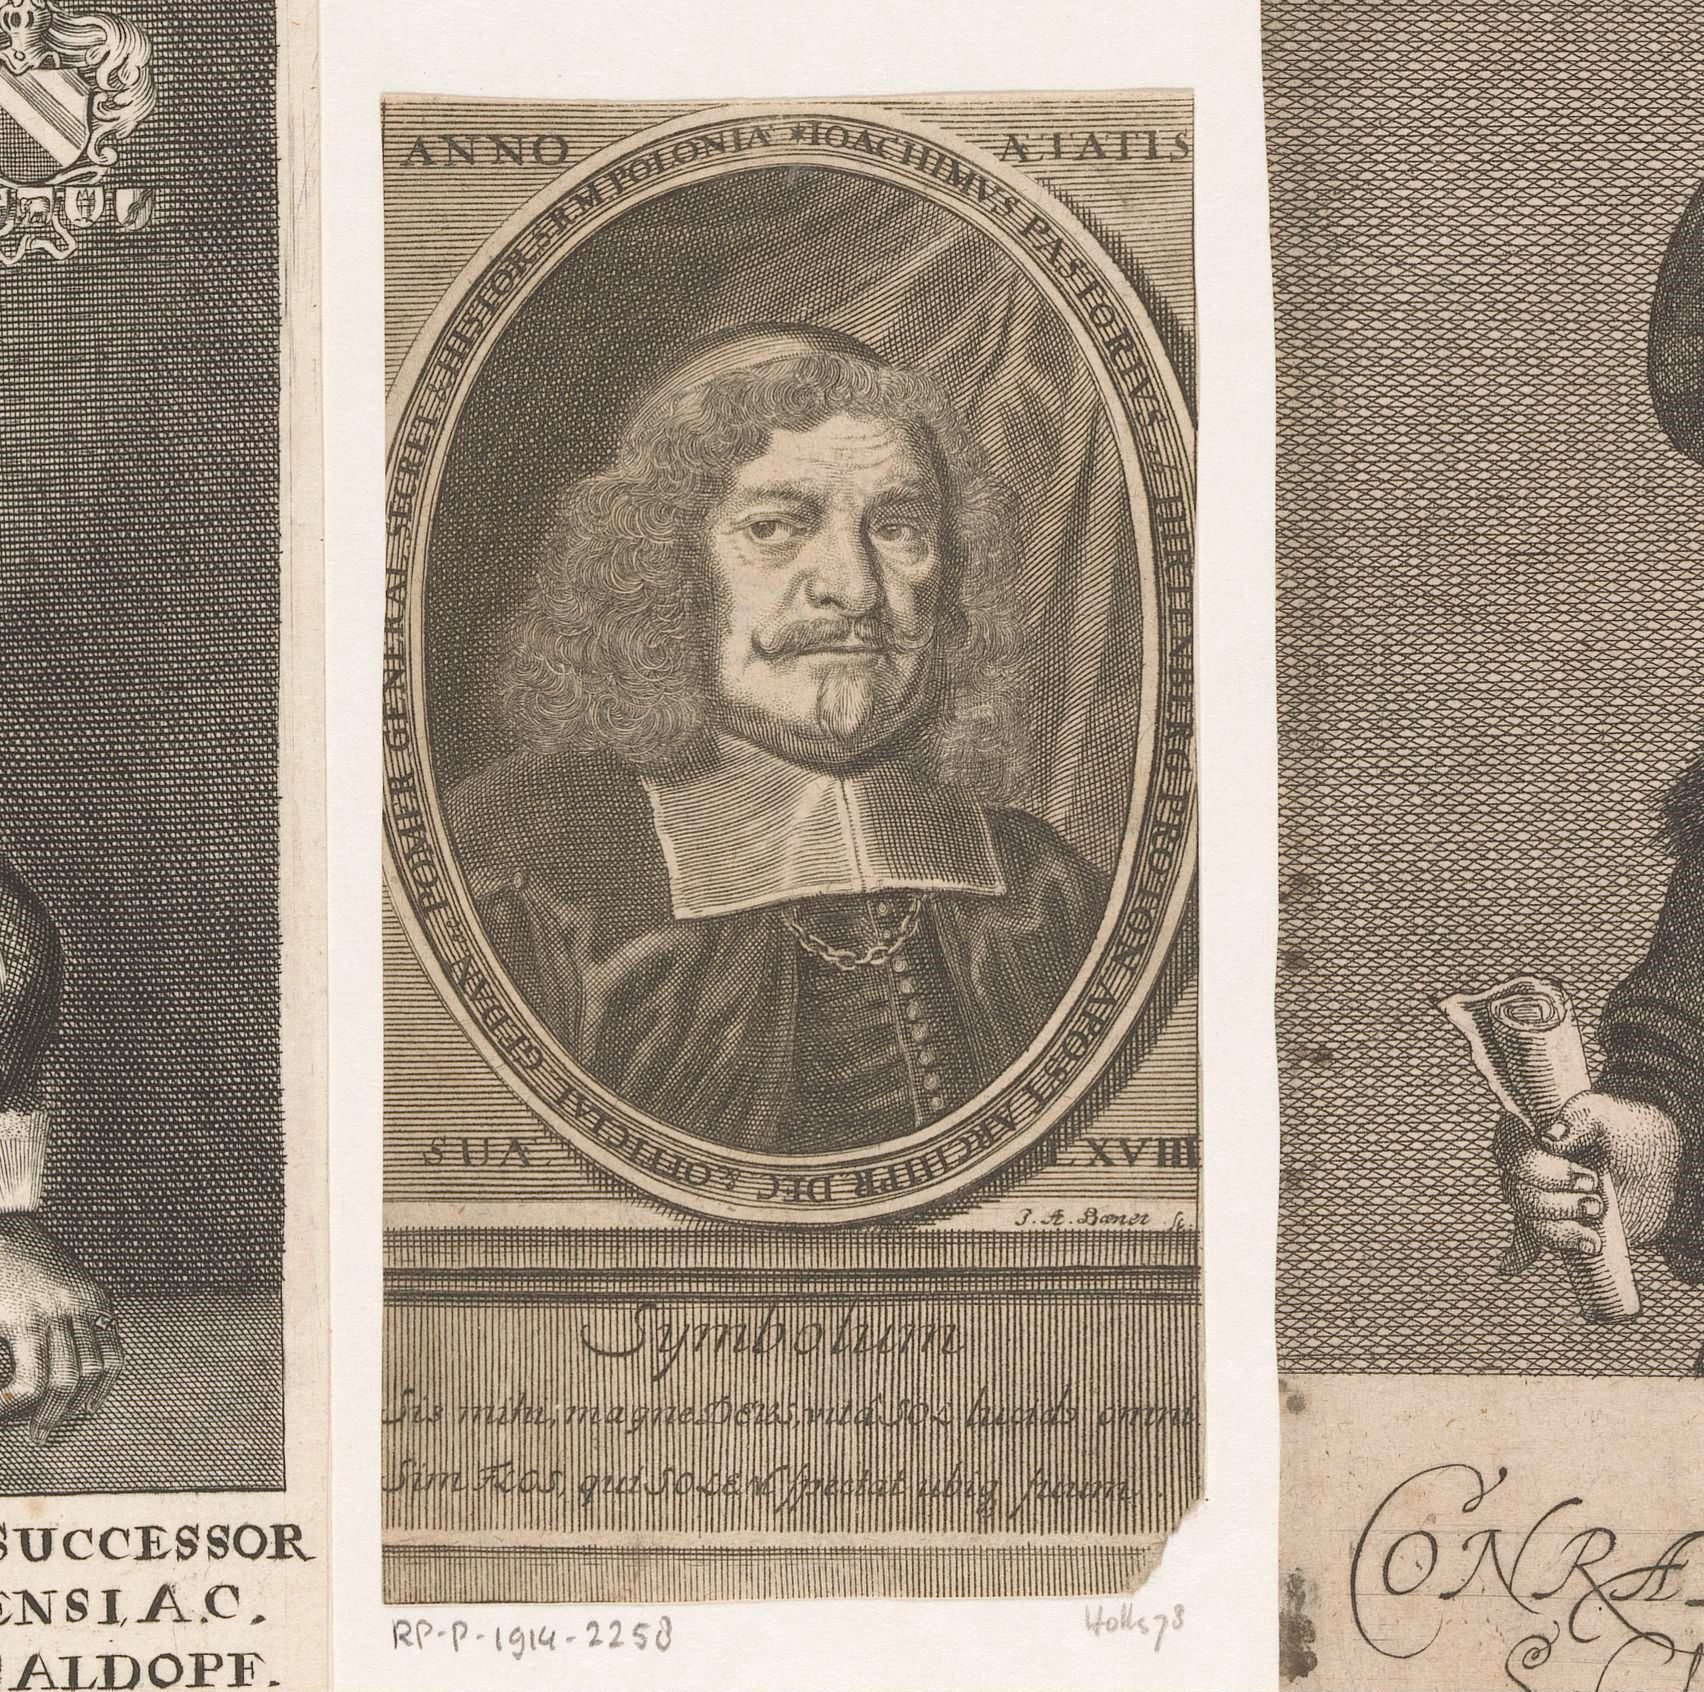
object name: print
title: Portret van Joachim Pastorius von Hirtenberg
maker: johann alexander böner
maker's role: draughtsman, print maker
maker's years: 1647-1720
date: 1679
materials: paper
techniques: engraving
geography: nuremberg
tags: historical persons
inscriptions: collector's mark: Lugt 2228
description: Prent ook gebruikt voor: Pastorius von Hirtenberg, Joachim. Florus Polonicus, Seu Polonicae Historiae Epitome nova (...). Danzig: Simon Beckenstein, 1679.